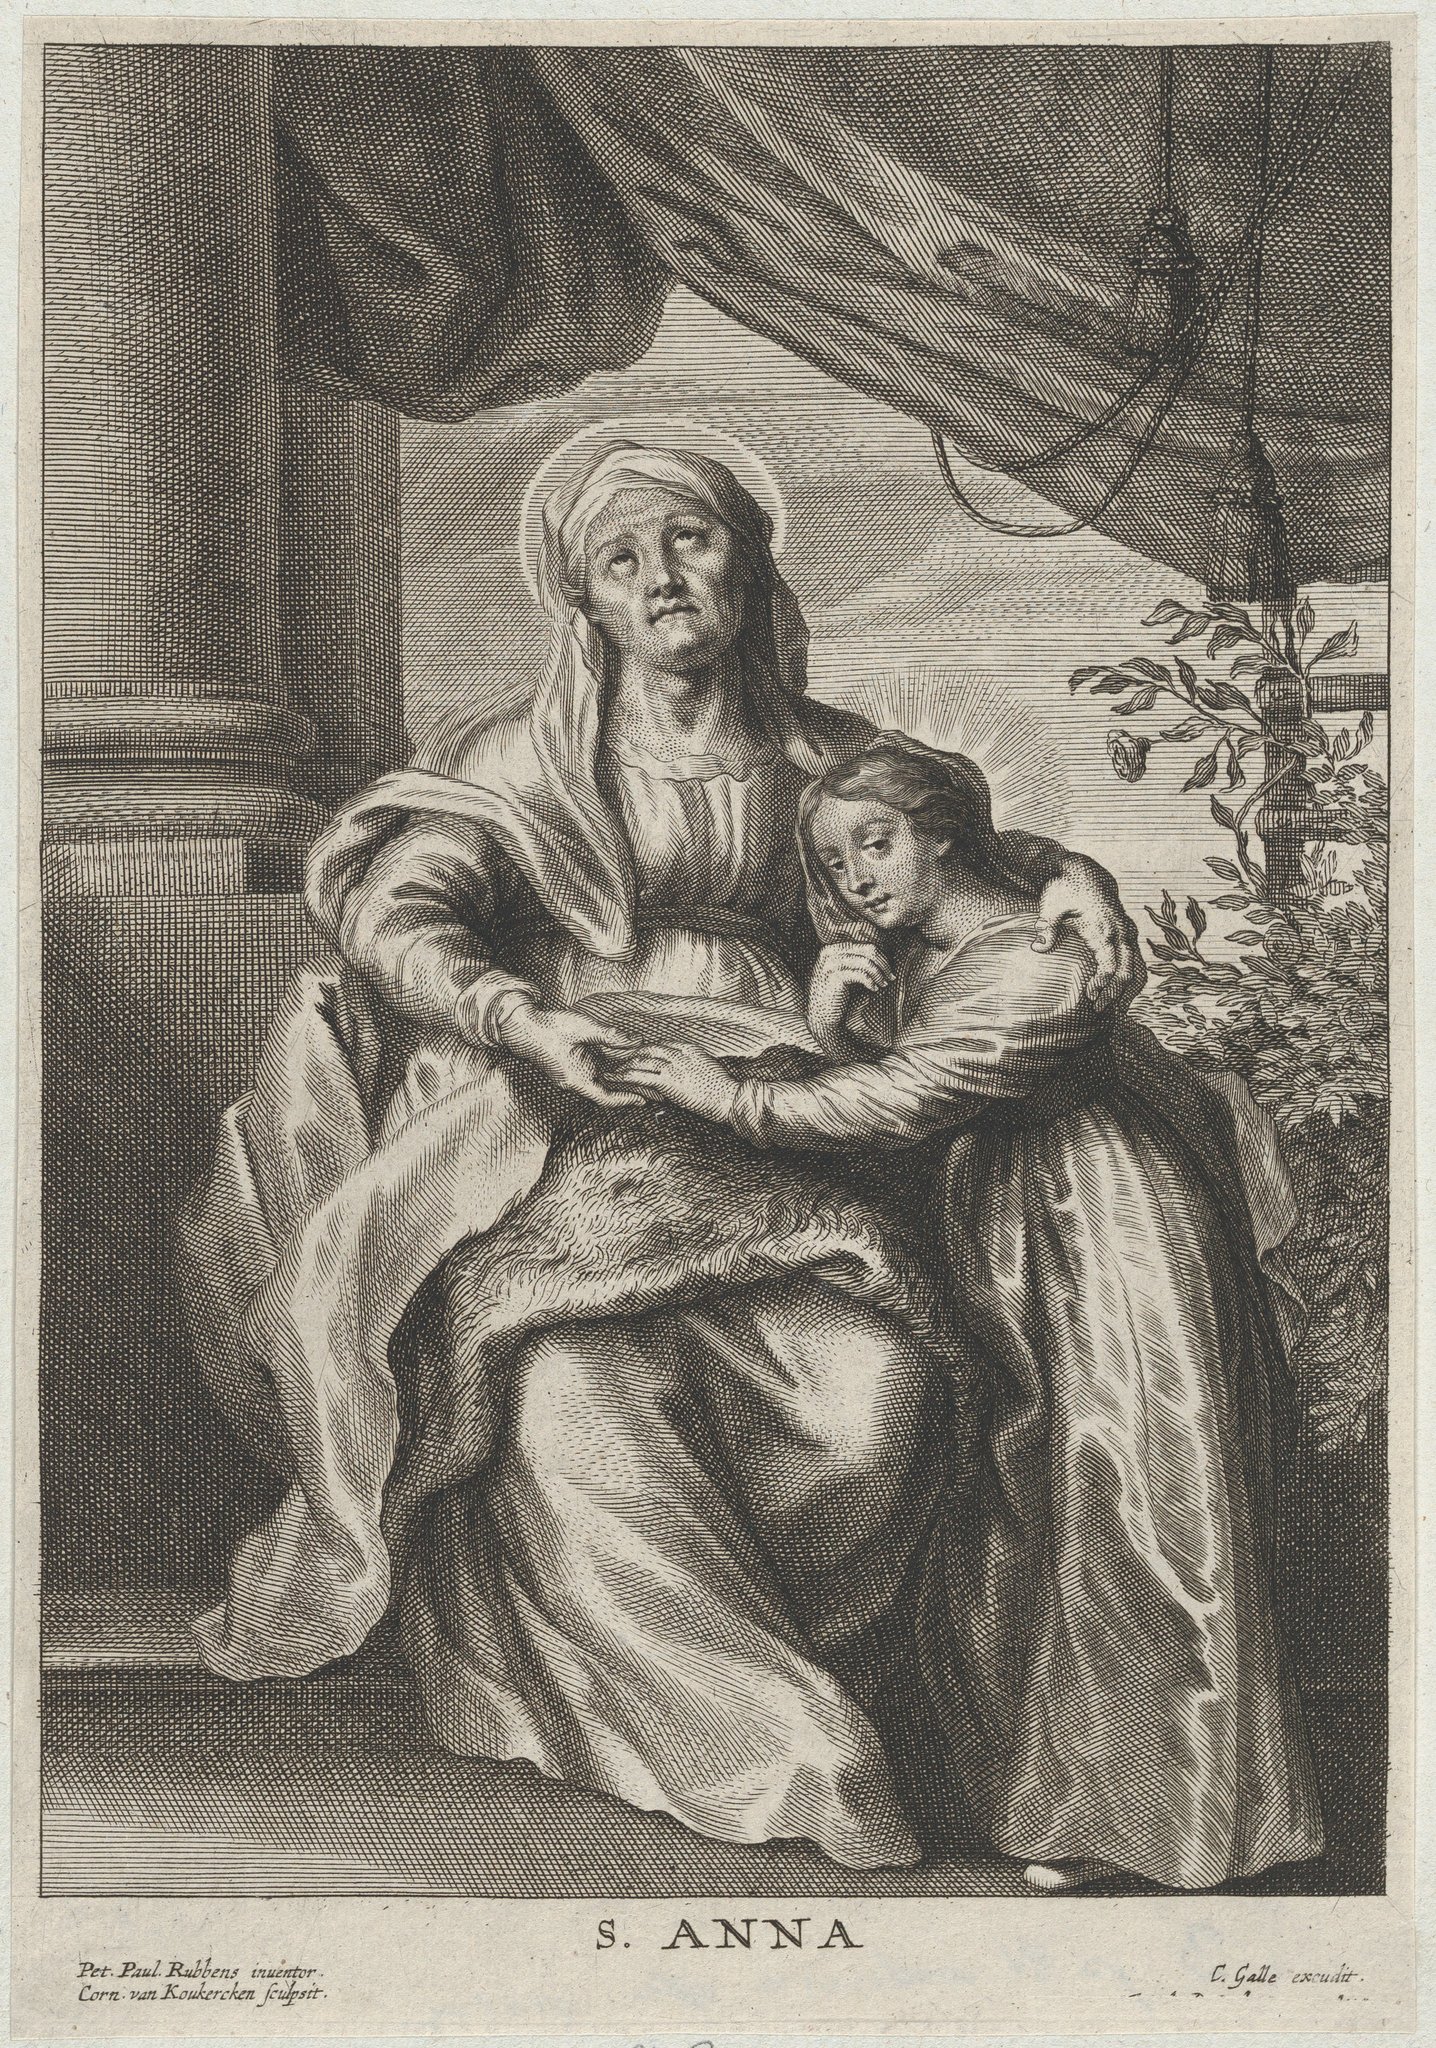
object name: print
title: The education of the Virgin, with Saint Anne seated on a bench looking upwards and putting her arm around the Virgin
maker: cornelis van caukercken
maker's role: artist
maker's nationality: flemish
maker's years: 1625-1680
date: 1645-1678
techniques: engraving, etching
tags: saint anne,virgin mary,education